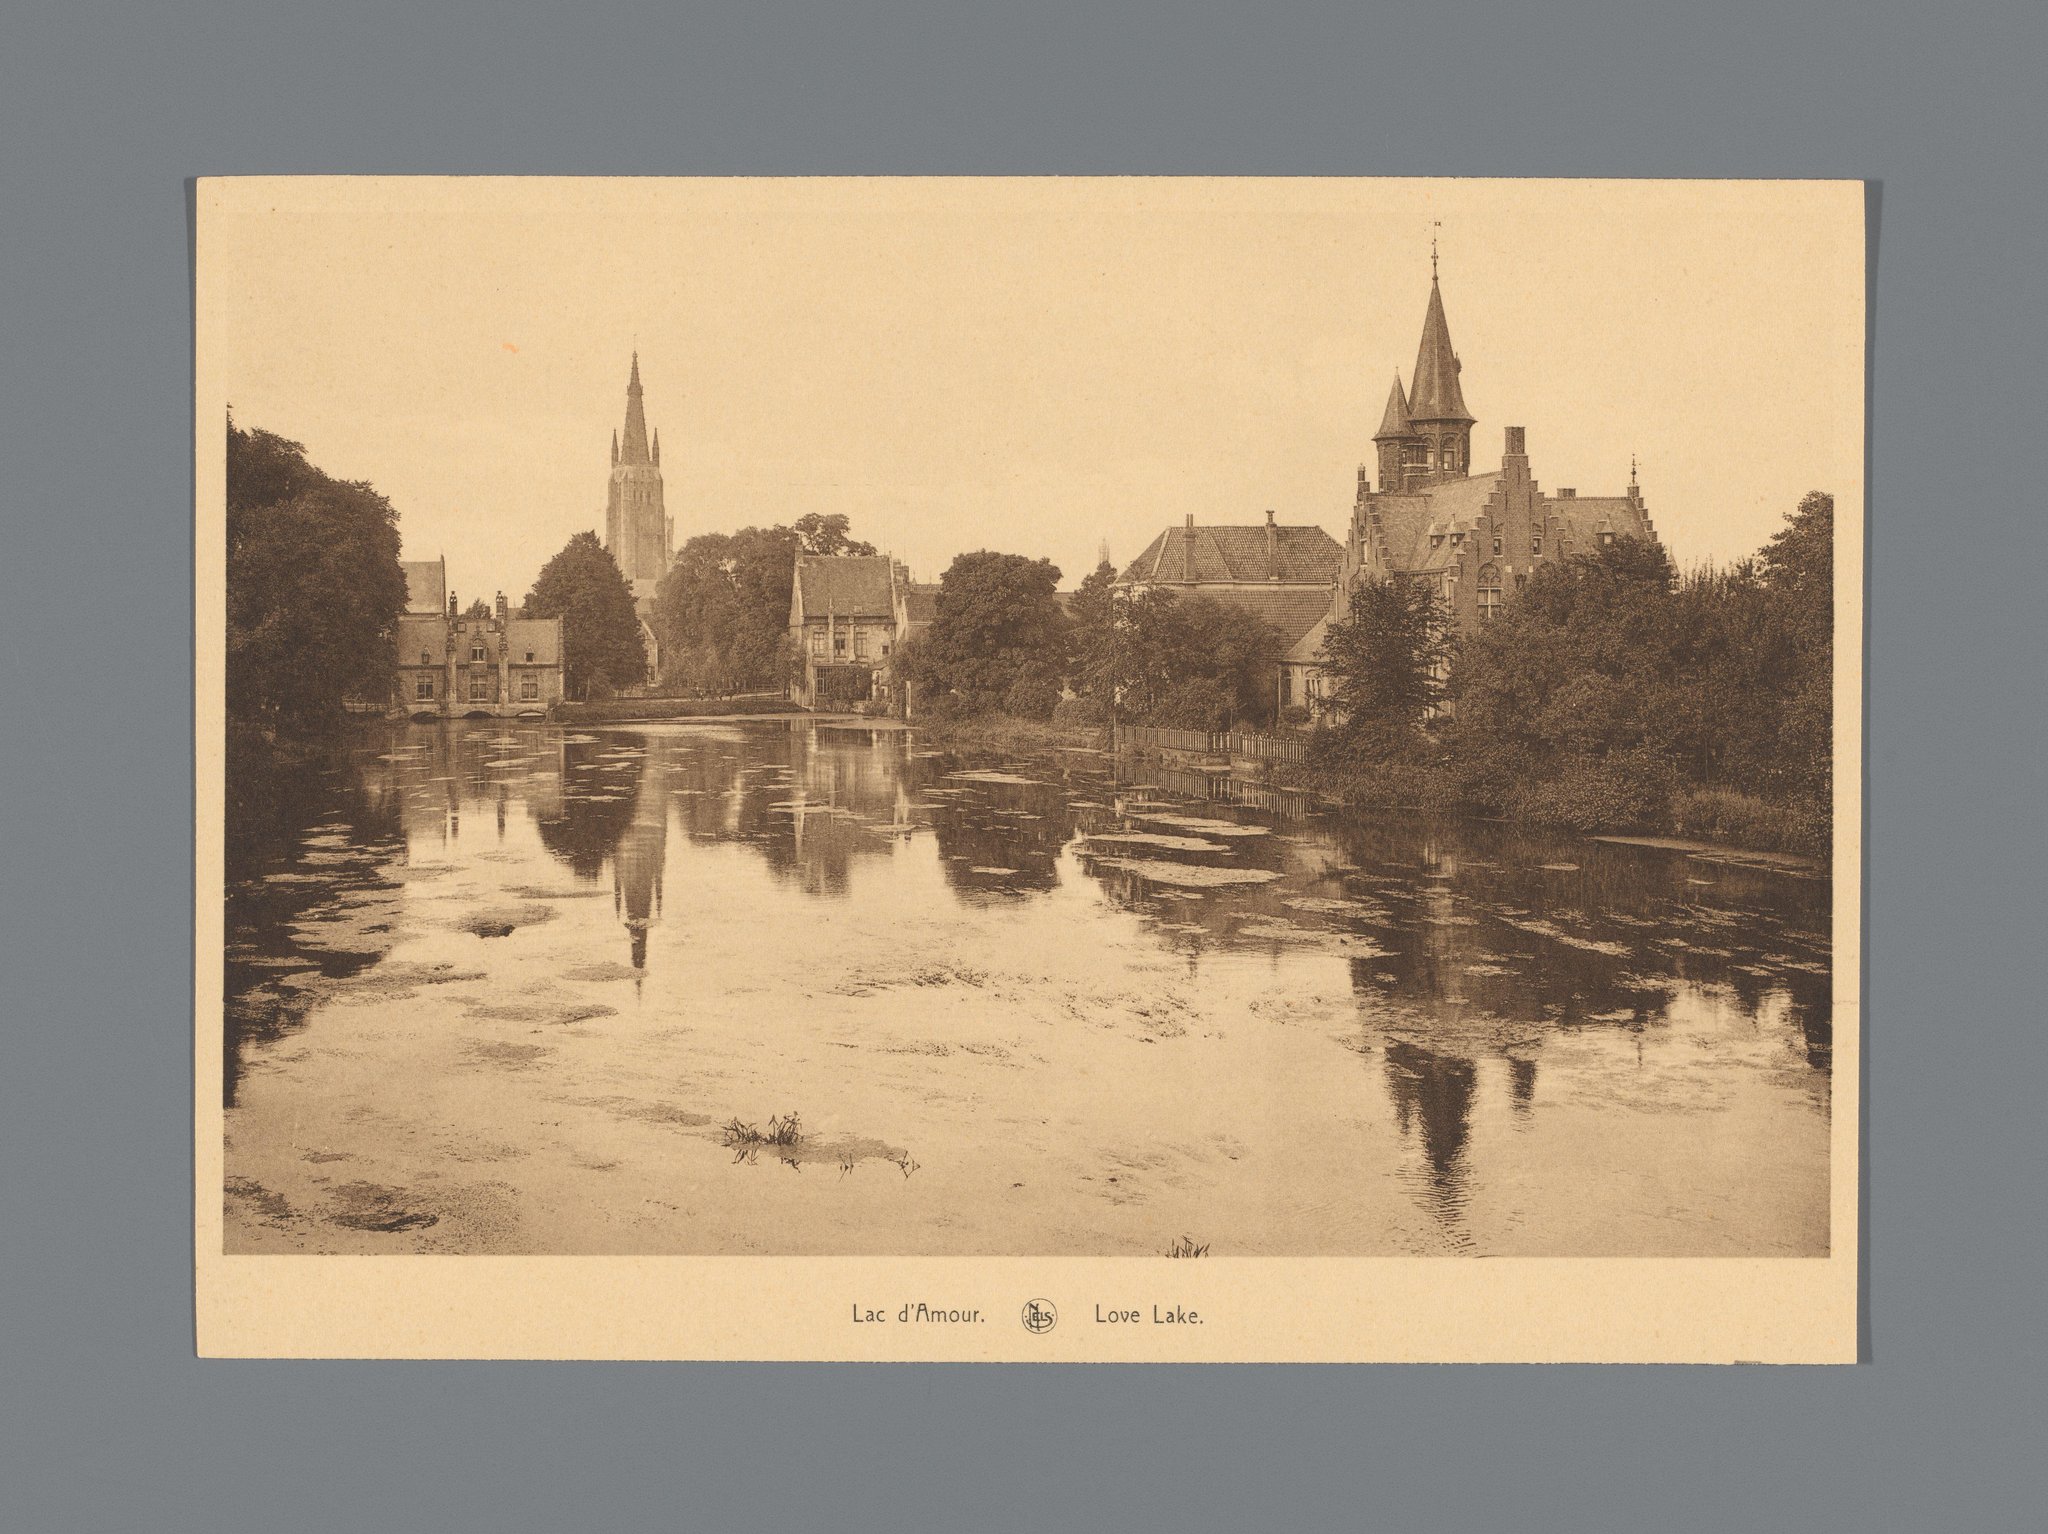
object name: photograph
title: Brugge. Lac d'Amour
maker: Anonymous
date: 1860-1925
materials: photographic support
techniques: photograph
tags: bruges